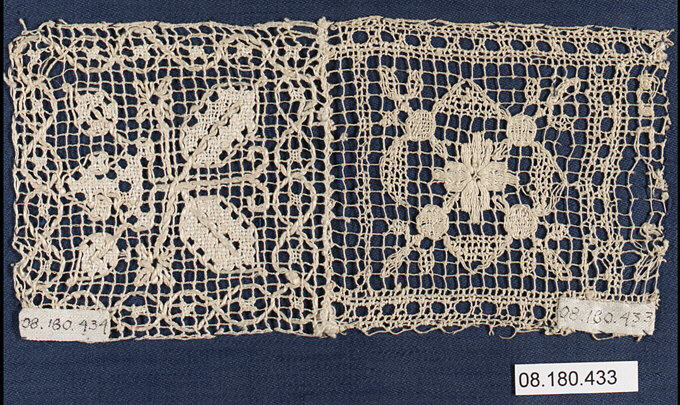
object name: square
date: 1601-1700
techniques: embroidery